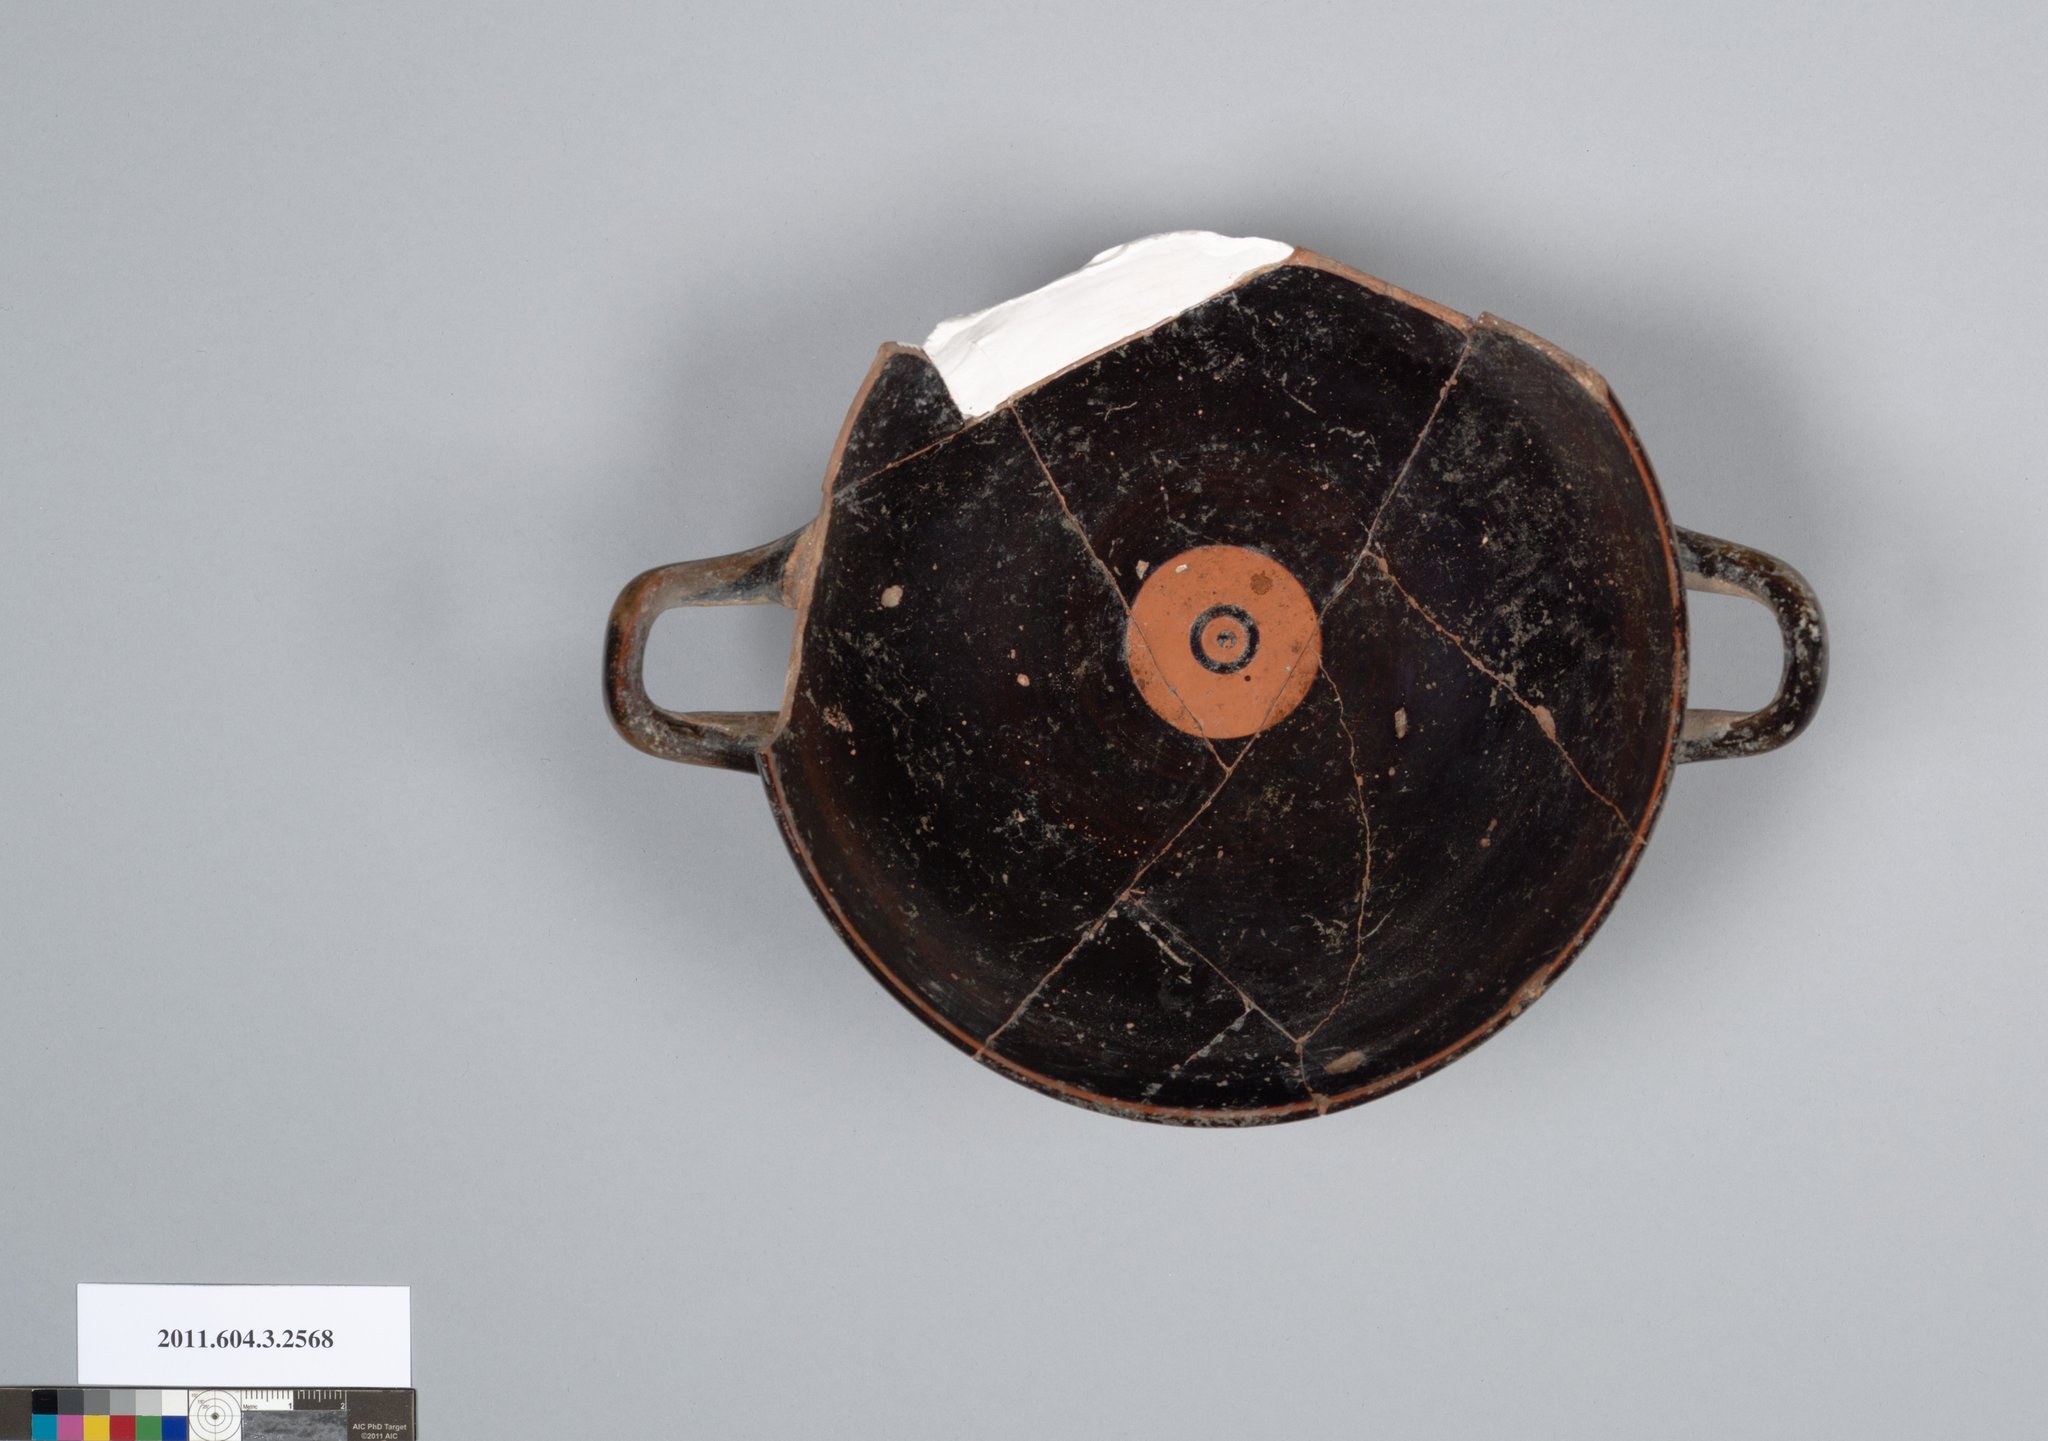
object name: kylix fragment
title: Terracotta fragment of a kylix: eye-cup (drinking cup)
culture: greek, attic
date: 525-510 BCE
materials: terracotta